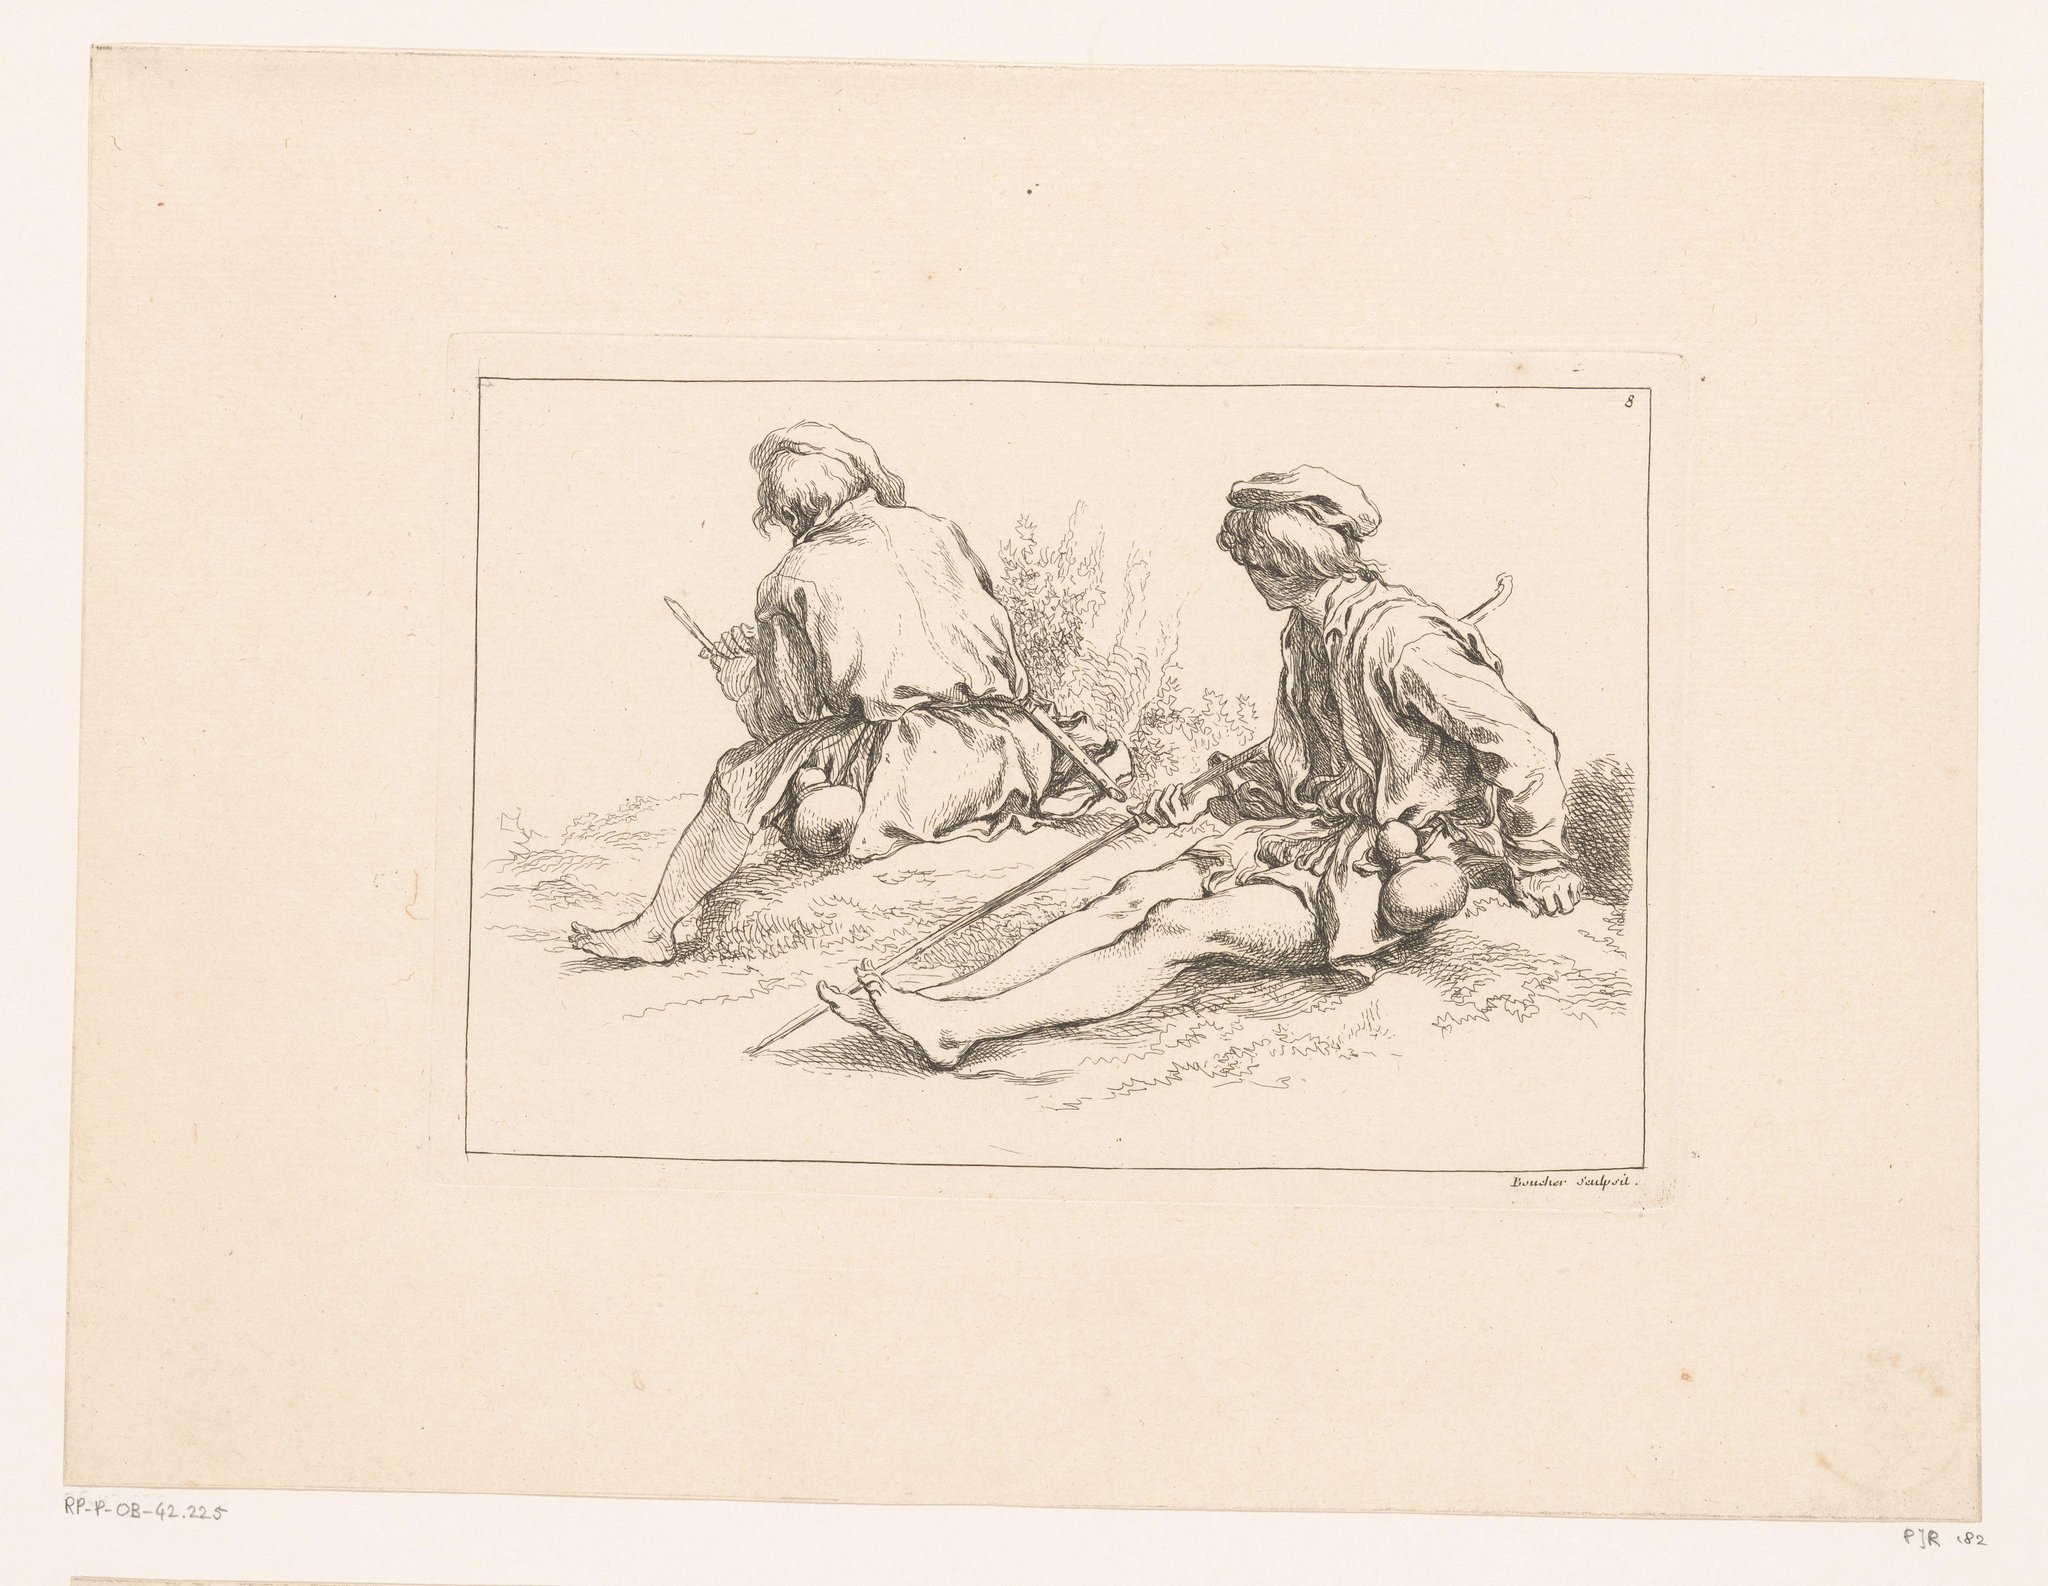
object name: print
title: Twee rustende figuren in een landschap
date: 1735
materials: paper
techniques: etching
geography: paris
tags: walking-stick, staff, sitting on the ground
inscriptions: collector's mark: Lugt 240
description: Maakt deel uit van een serie van twaalf prenten naar tekeningen door Abraham Bloemaert, getiteld 'Livre d'Etude d'après les Desseins Originaux de Blomart'.